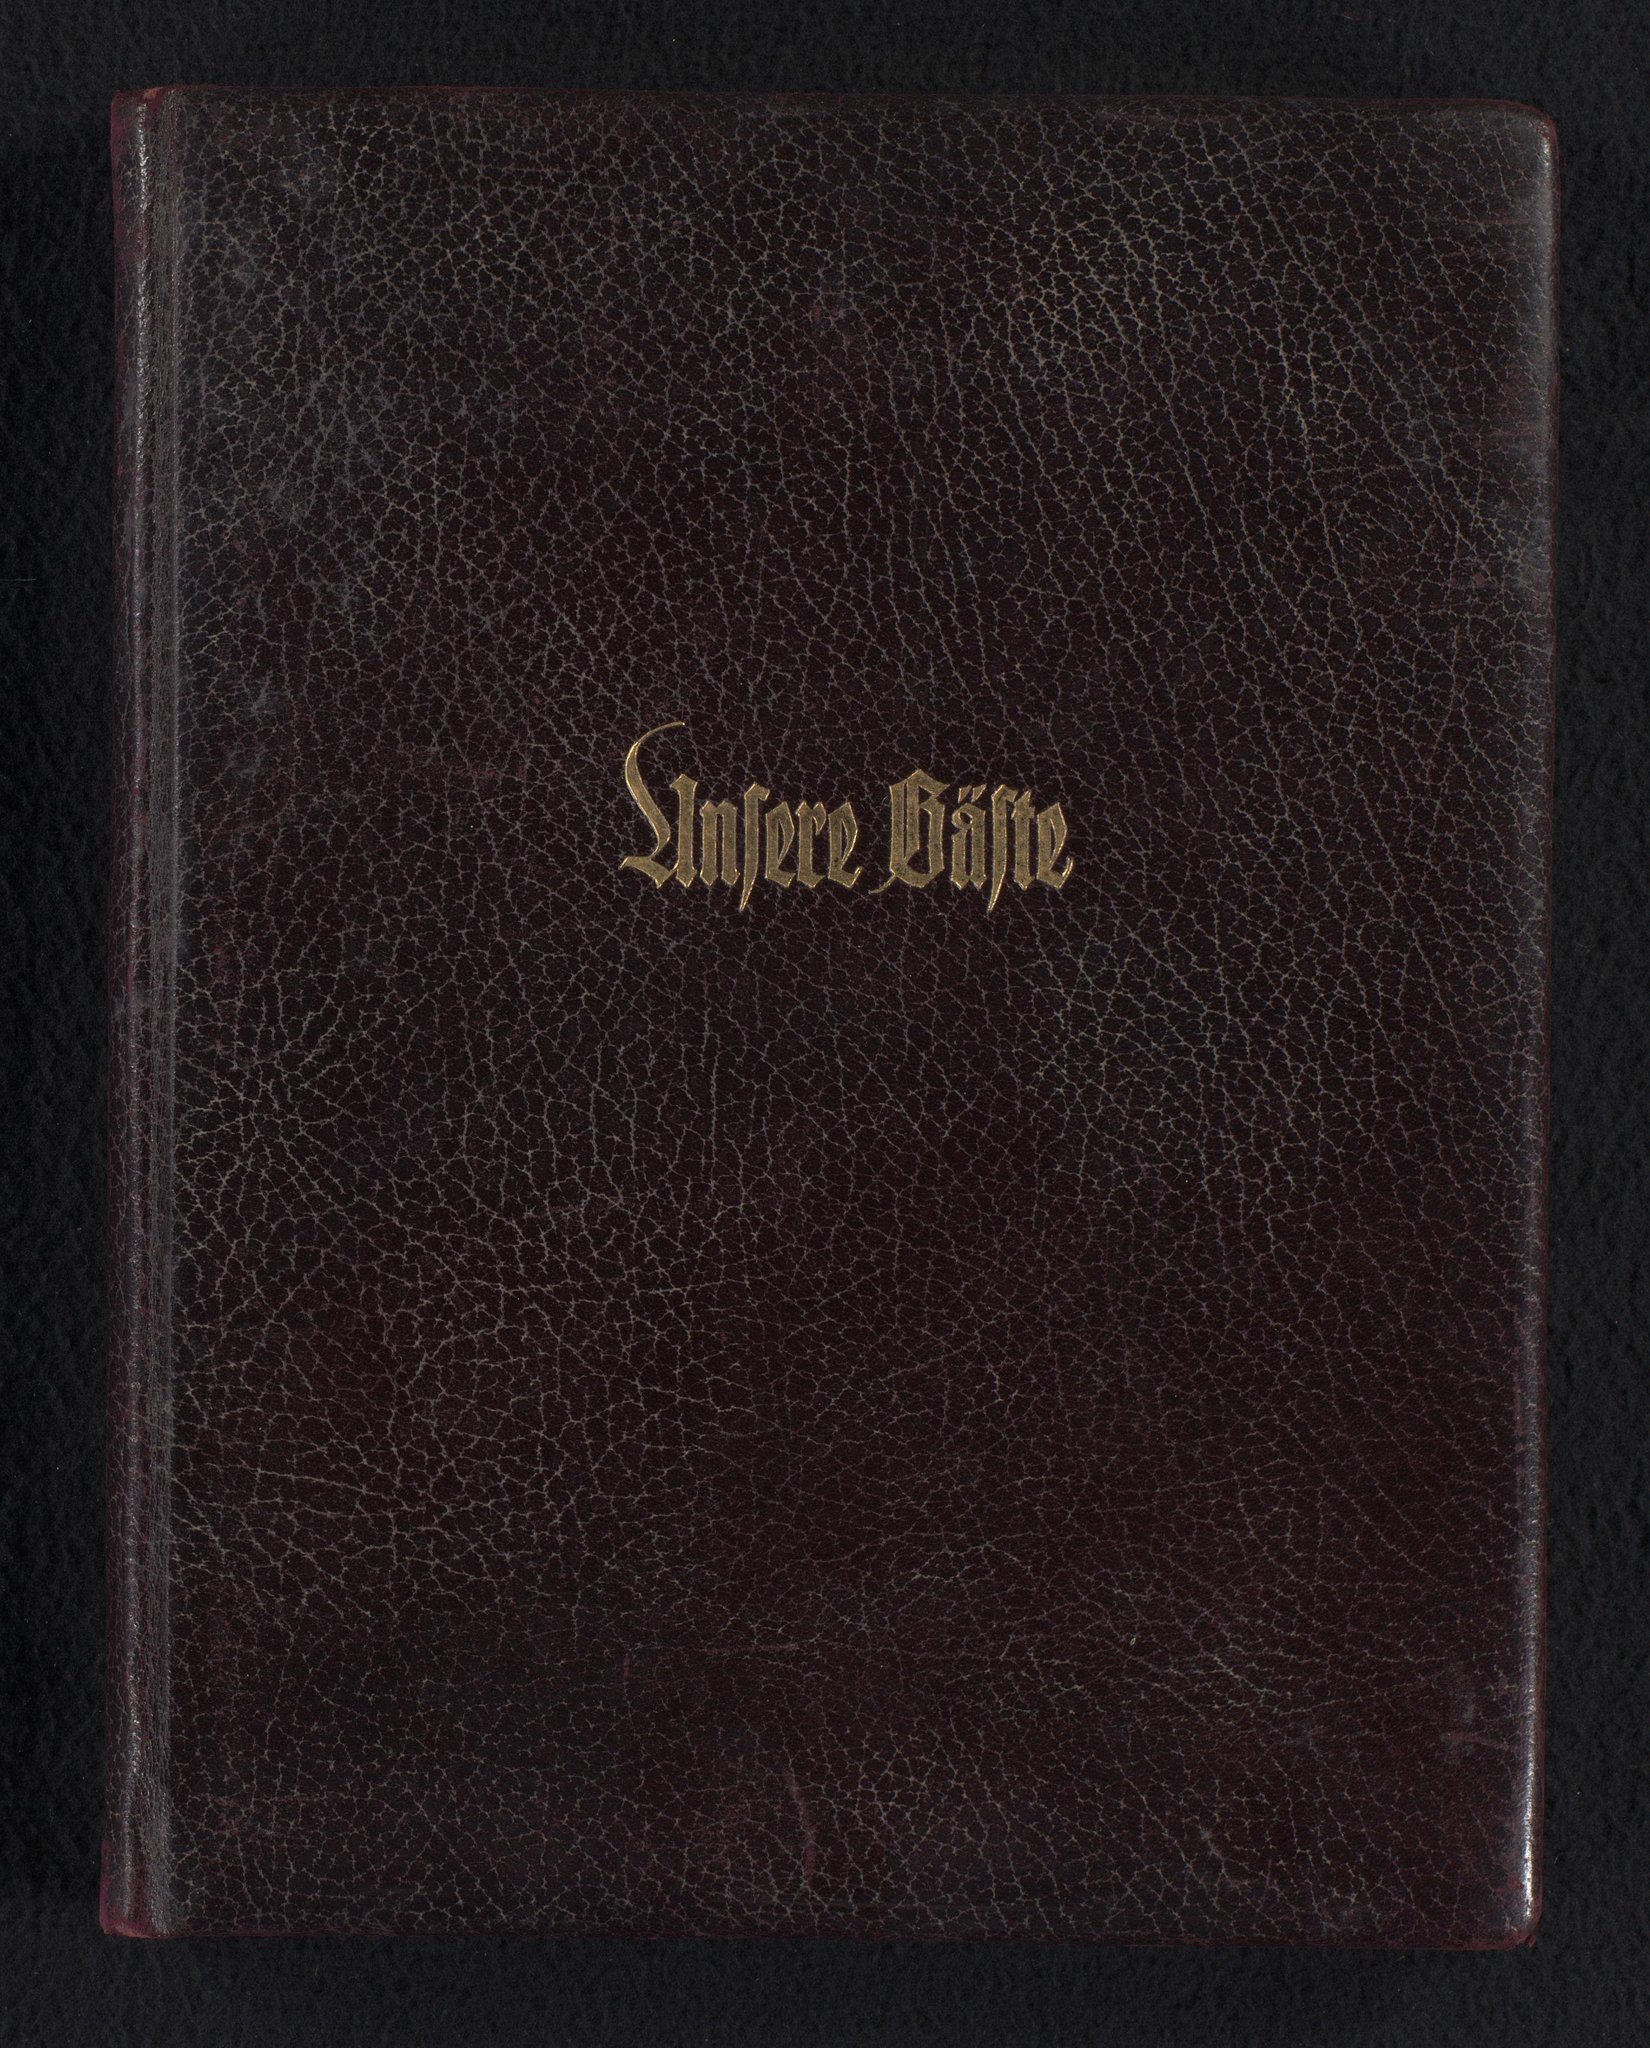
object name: visitors' book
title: Unsere Besuche am 12. u. 13. August 1922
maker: else wachenheimer-moos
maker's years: 1895-1944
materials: ink, leather, paper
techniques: handwriting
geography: stuttgart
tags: eugen wachenheimer, else wachenheimer-moos, handwriting, written text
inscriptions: date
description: Dit object is onderdeel van de nalatenschap van Isabel Elon-Wachenheimer (1928-2010). Tot haar overlijden behoorde het samen met de andere objecten uit de nalatenschap tot haar privédomein van Isabel Wachenheimer. In die particuliere context zijn deze objecten tezamen en individueel aandenkens - aan de jeugd, ouders en familie van Isabel Wachenheimer vóór en tijdens de Shoah en aan haar leven na de Tweede Wereldoorlog. Isabel Wachenheimer, die van juni 1943 tot mei 1945 gevangen zat in Kamp Westerbork, Theresienstadt, Auschwitz, Lenzing a/d Oberdonau (een buitenkamp van Mauthausen), overleefde de Shoah. Haar ouders – Eugène Wachenheimer en Else Wachenheimer-Moos - werden op 14 oktober 1944 in Auschwitz-Birkenau vermoord.